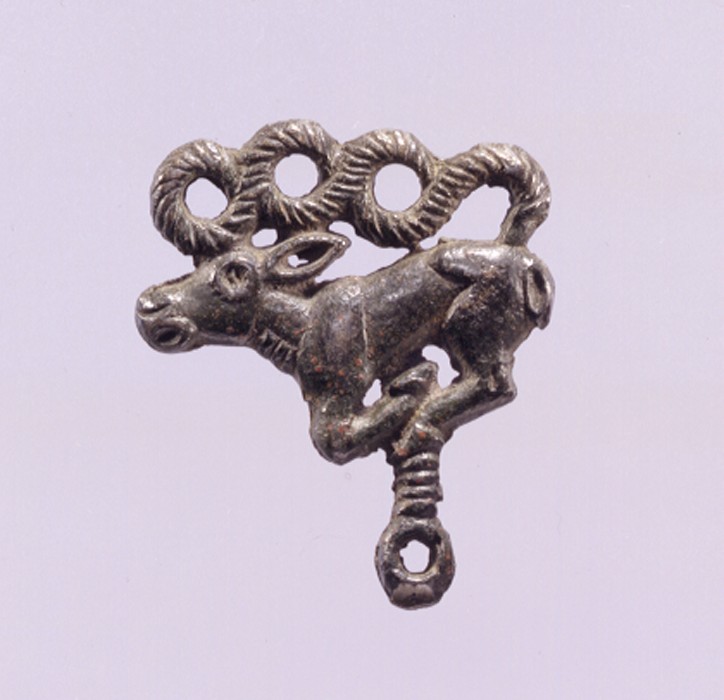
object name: ornament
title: Ornament in the Shape of a Stag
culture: chinese, northeast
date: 600-501 BCE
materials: bronze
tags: deer